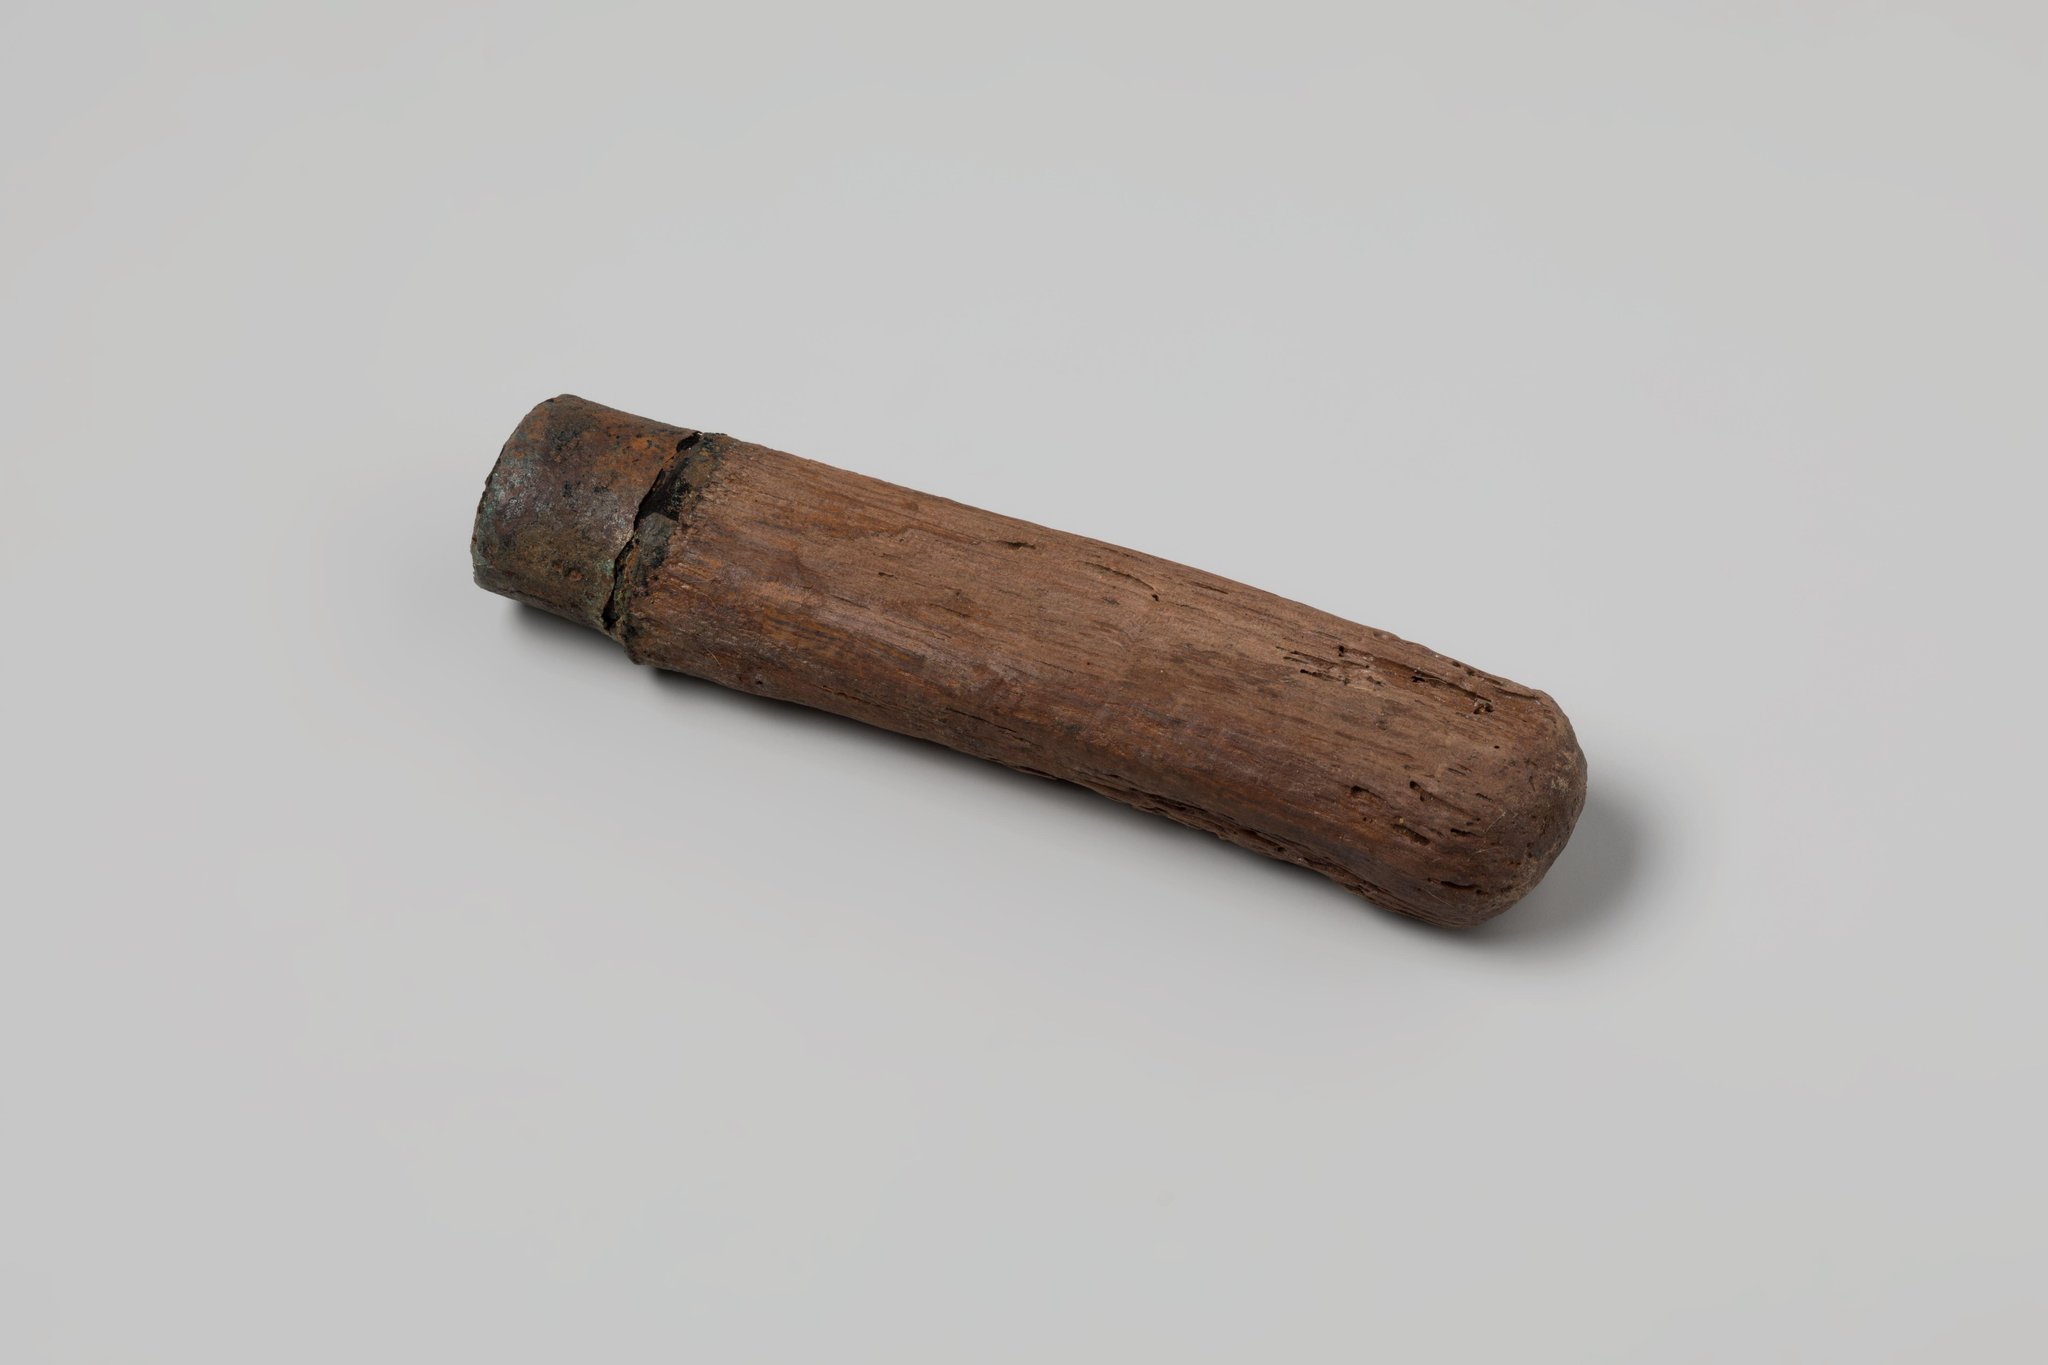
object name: knife handle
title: Messenheft uit het wrak van de Oost-Indiëvaarder Hollandia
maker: Anonymous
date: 1700-1743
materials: metal, wood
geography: netherlands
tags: verenigde oostindische compagnie, hollandia (schip), annet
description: Knife-handle, straight; oblong, upper end rounded, rectangular in section, lower end oval with ferrule.